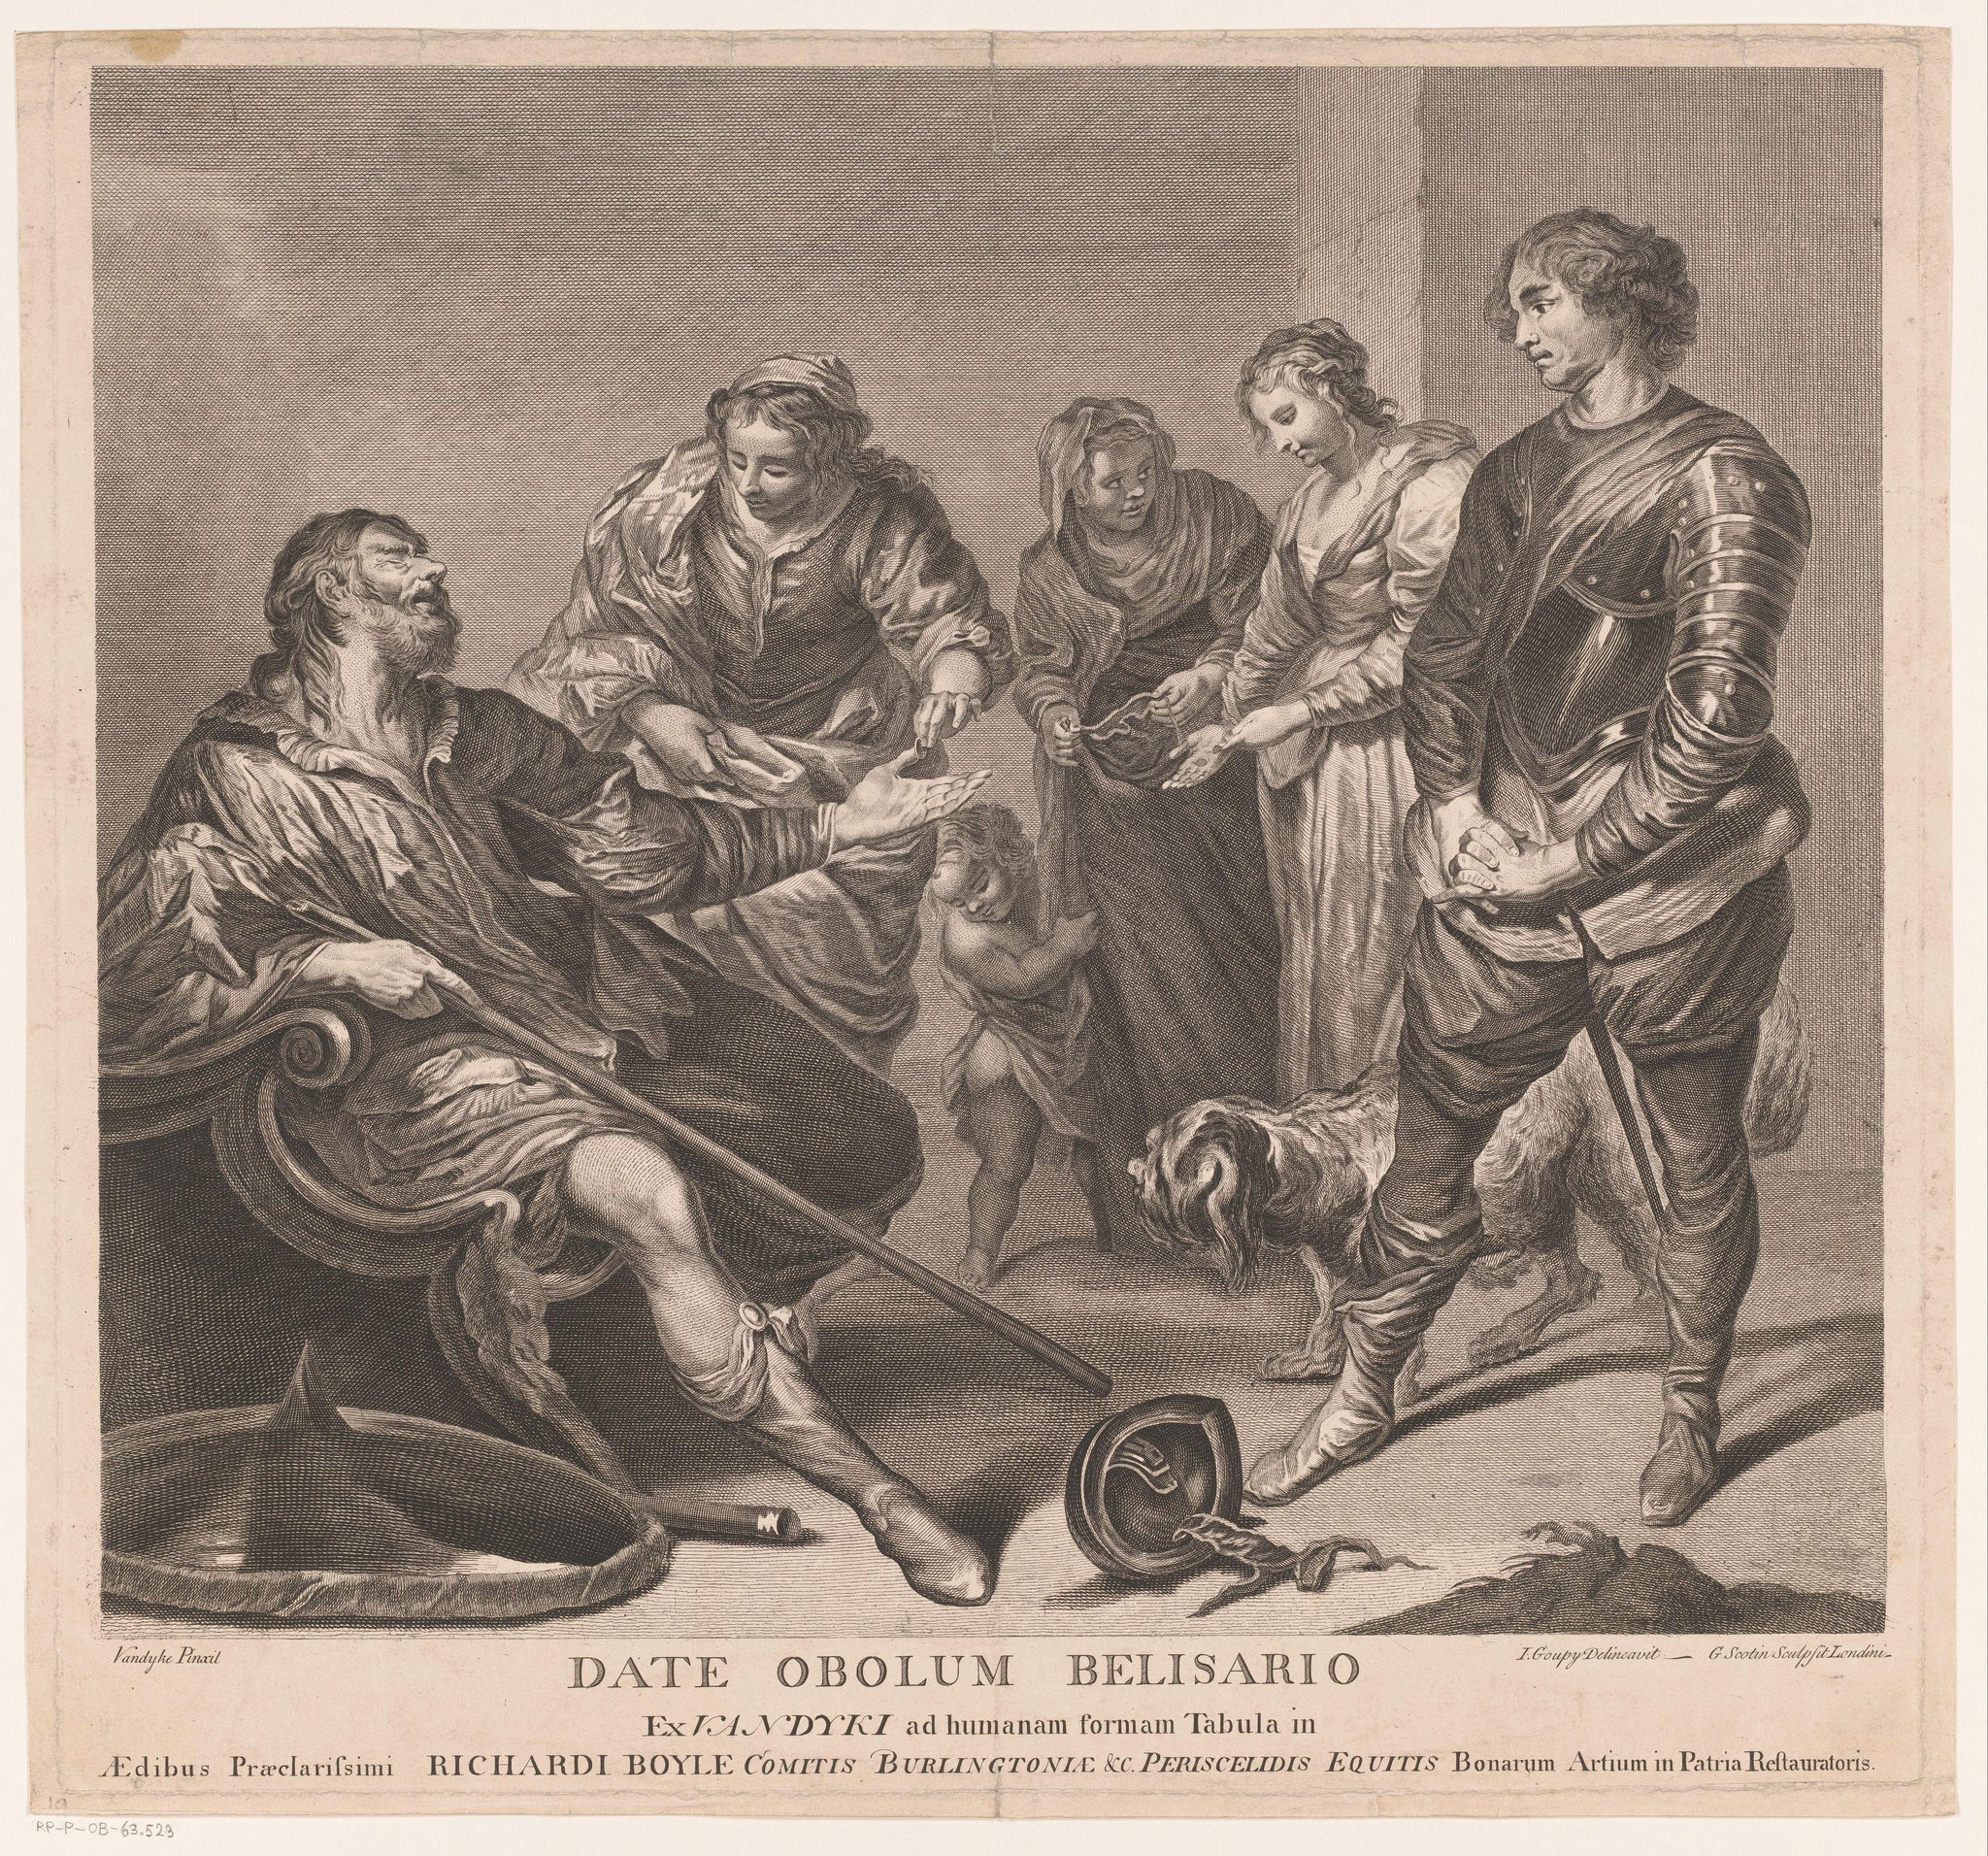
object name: print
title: Belisarius krijgt een aalmoes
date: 1708-1733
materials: paper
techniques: engraving, etching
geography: london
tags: blind, blindness, beggar, belisarius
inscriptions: collector's mark: Lugt 240